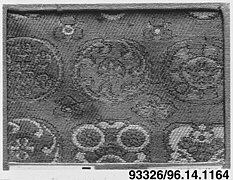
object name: piece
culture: japanese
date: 1701-1900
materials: silk